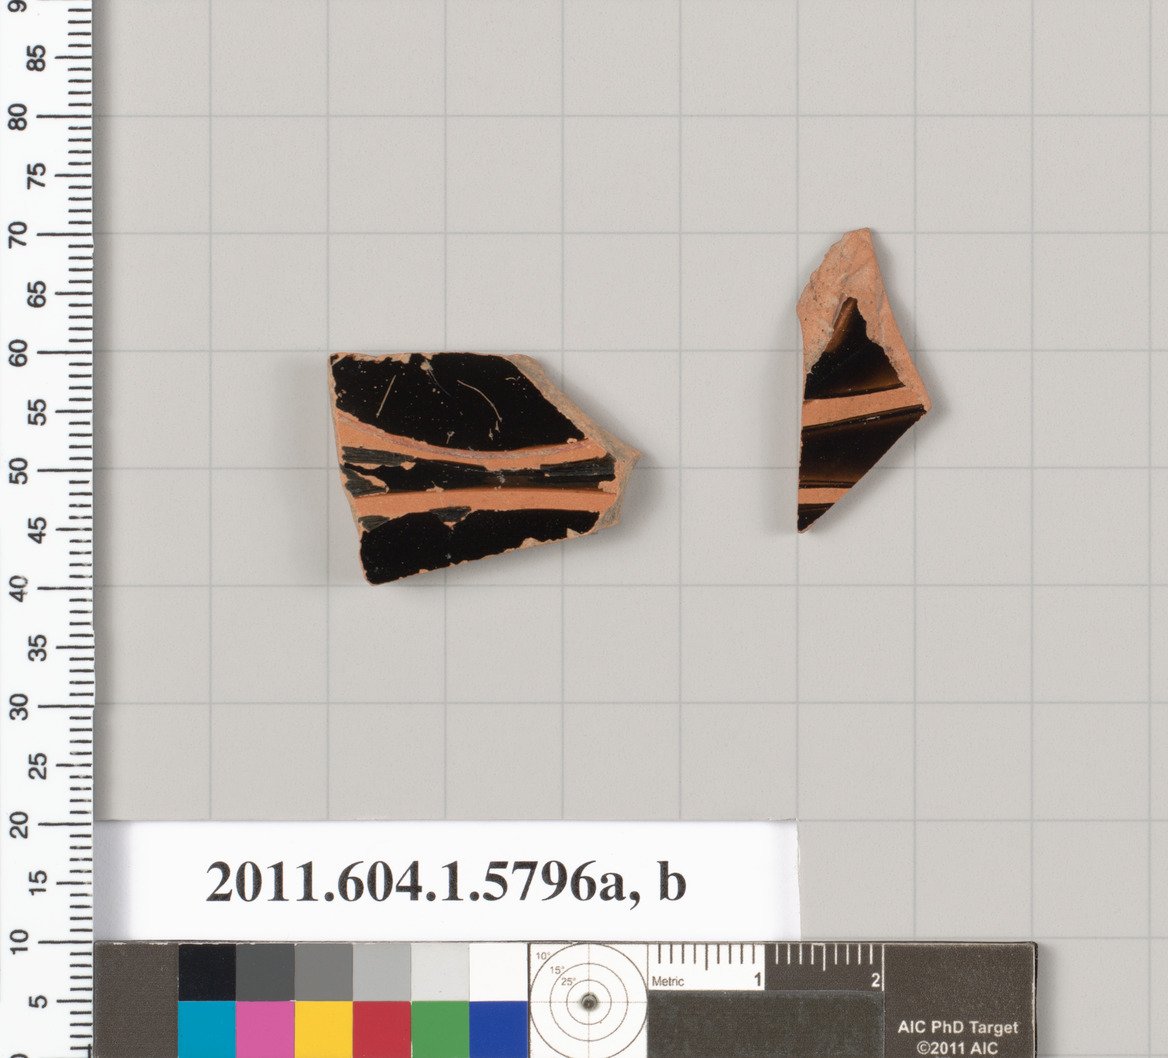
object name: kylix fragment, eye cup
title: Terracotta fragments of kylikes: eye-cups (drinking cups)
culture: greek, attic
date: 525-510 BCE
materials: terracotta